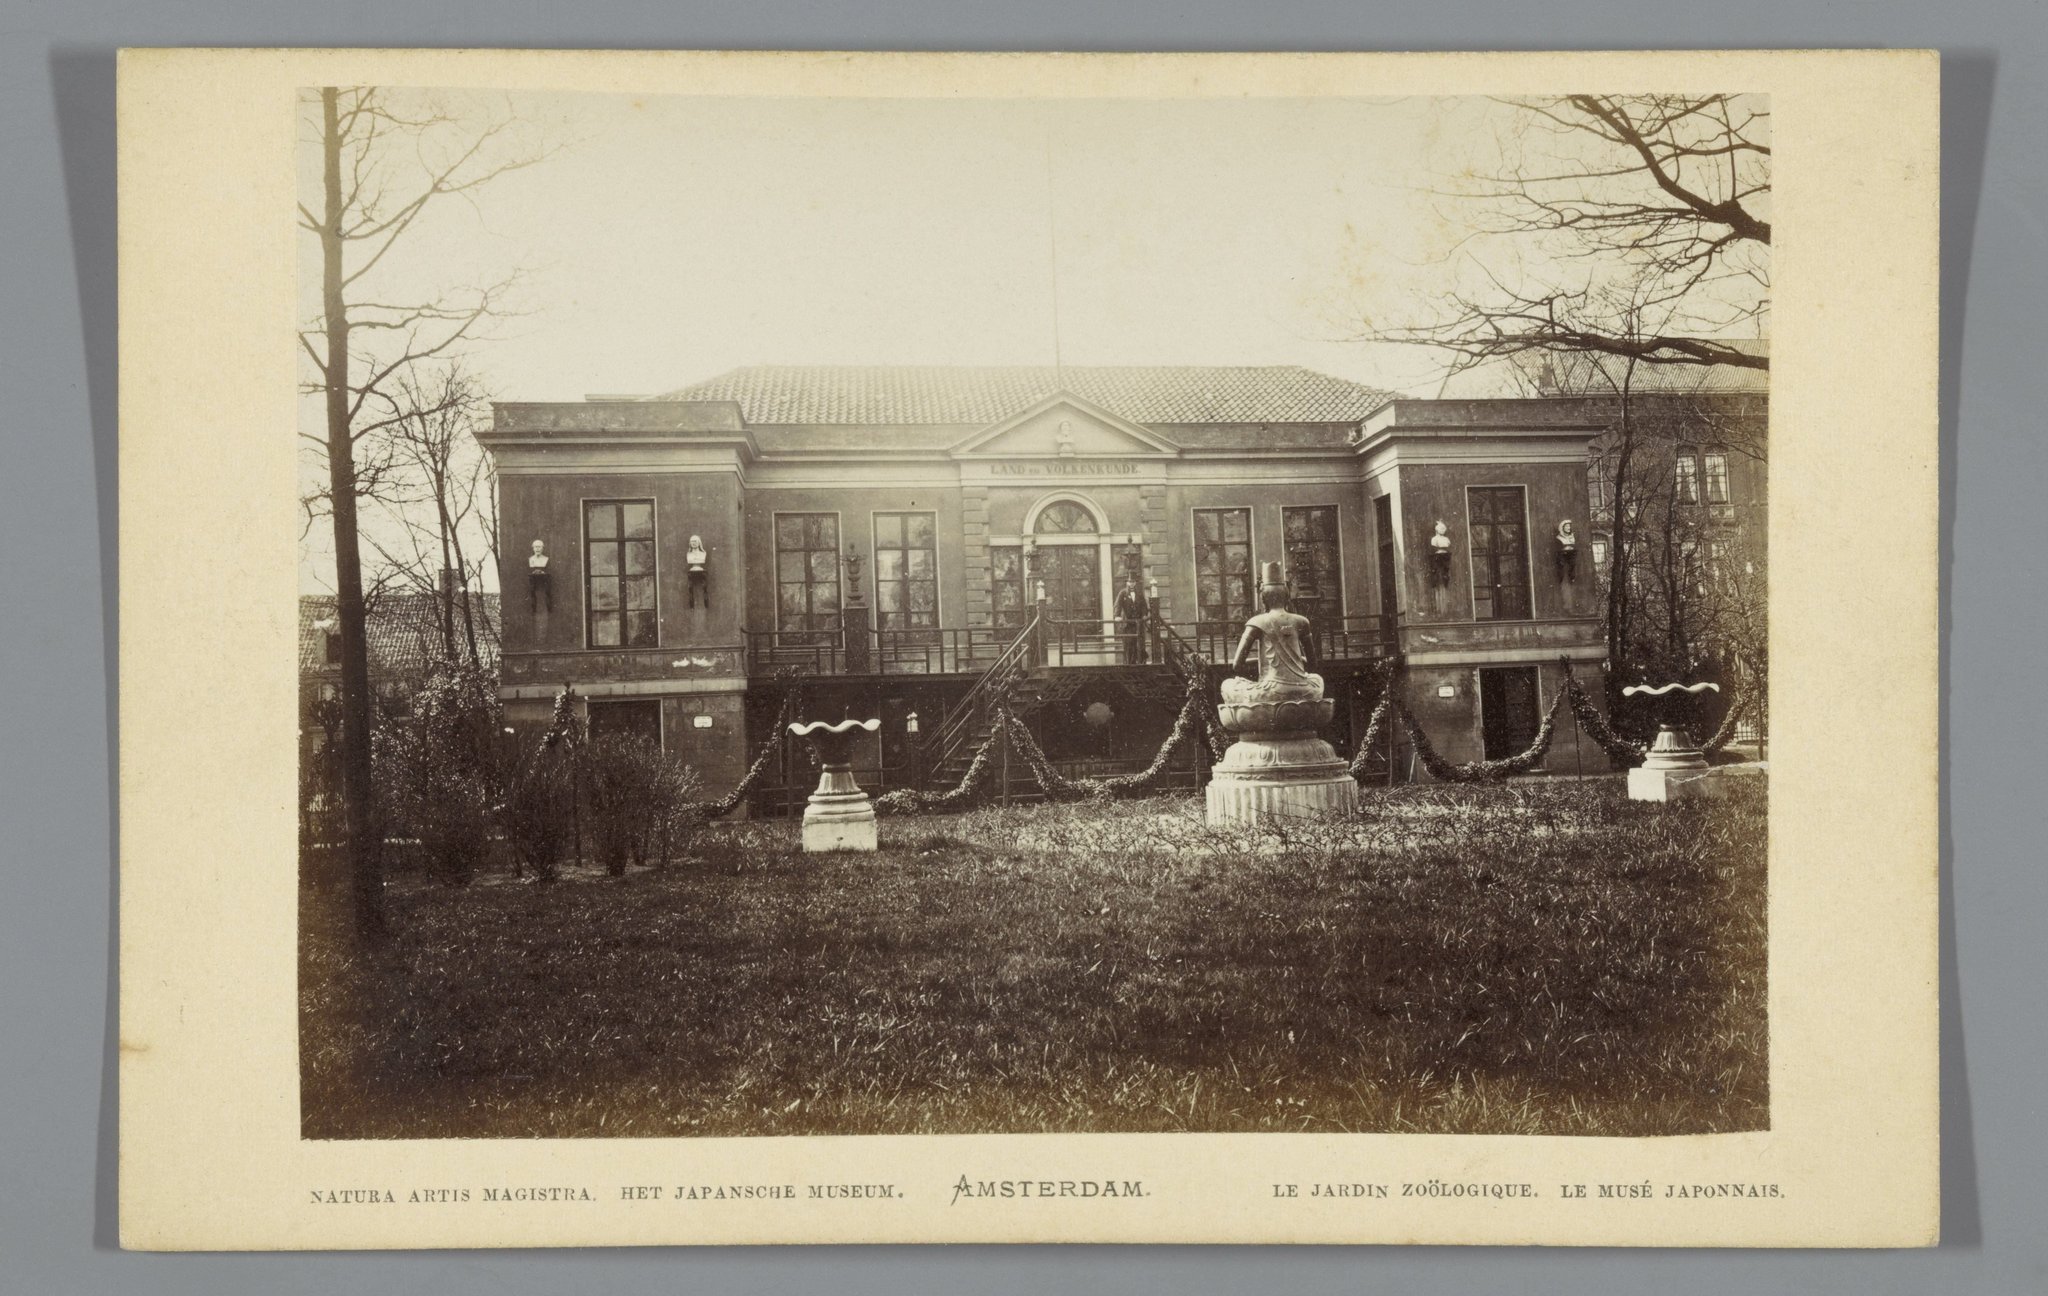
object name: cabinet photograph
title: Gezicht op het Japansch Museum in Artis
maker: andries jager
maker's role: publisher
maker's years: 1825-1905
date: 1860-1890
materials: cardboard, photographic support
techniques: albumen print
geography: amsterdam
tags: permanent exhibition, museum, zoological garden, zoo, seen as place where non-domestic animals are kept